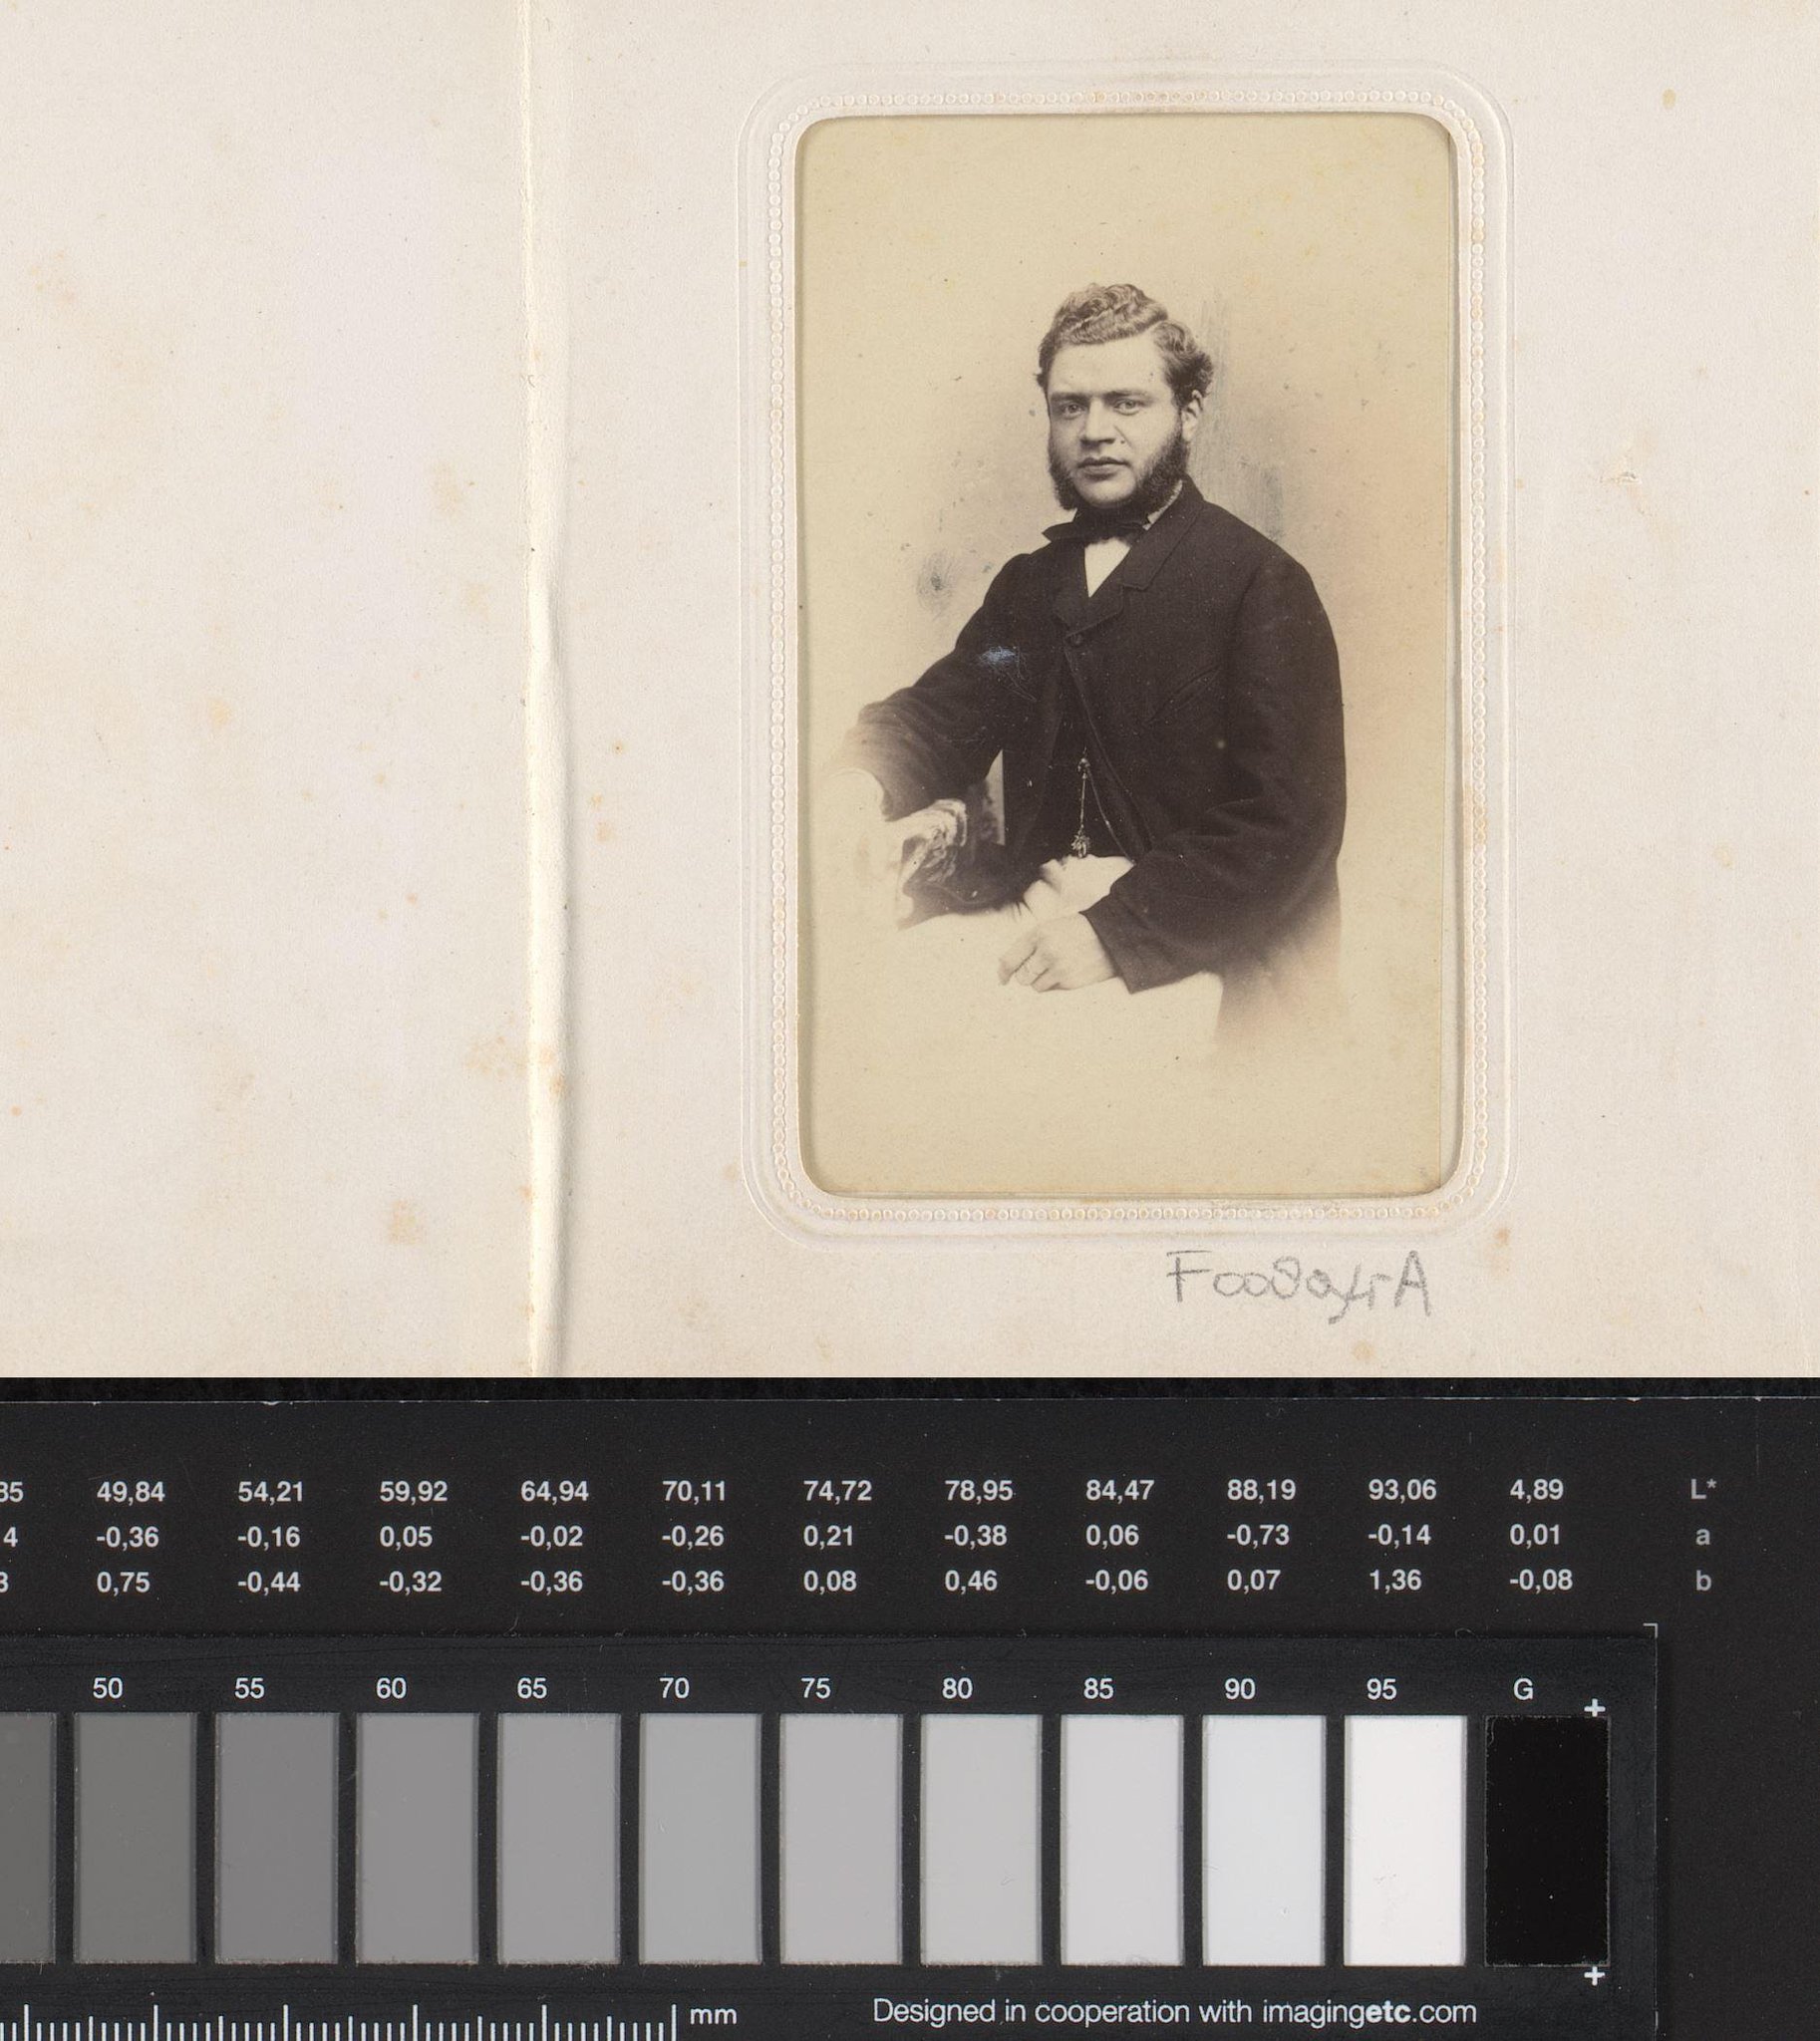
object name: carte de visite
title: Portret van een man met bakkenbaarden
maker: Anonymous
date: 1855-1890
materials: cardboard, photographic support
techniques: albumen print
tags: sideburns, adult man, historical persons